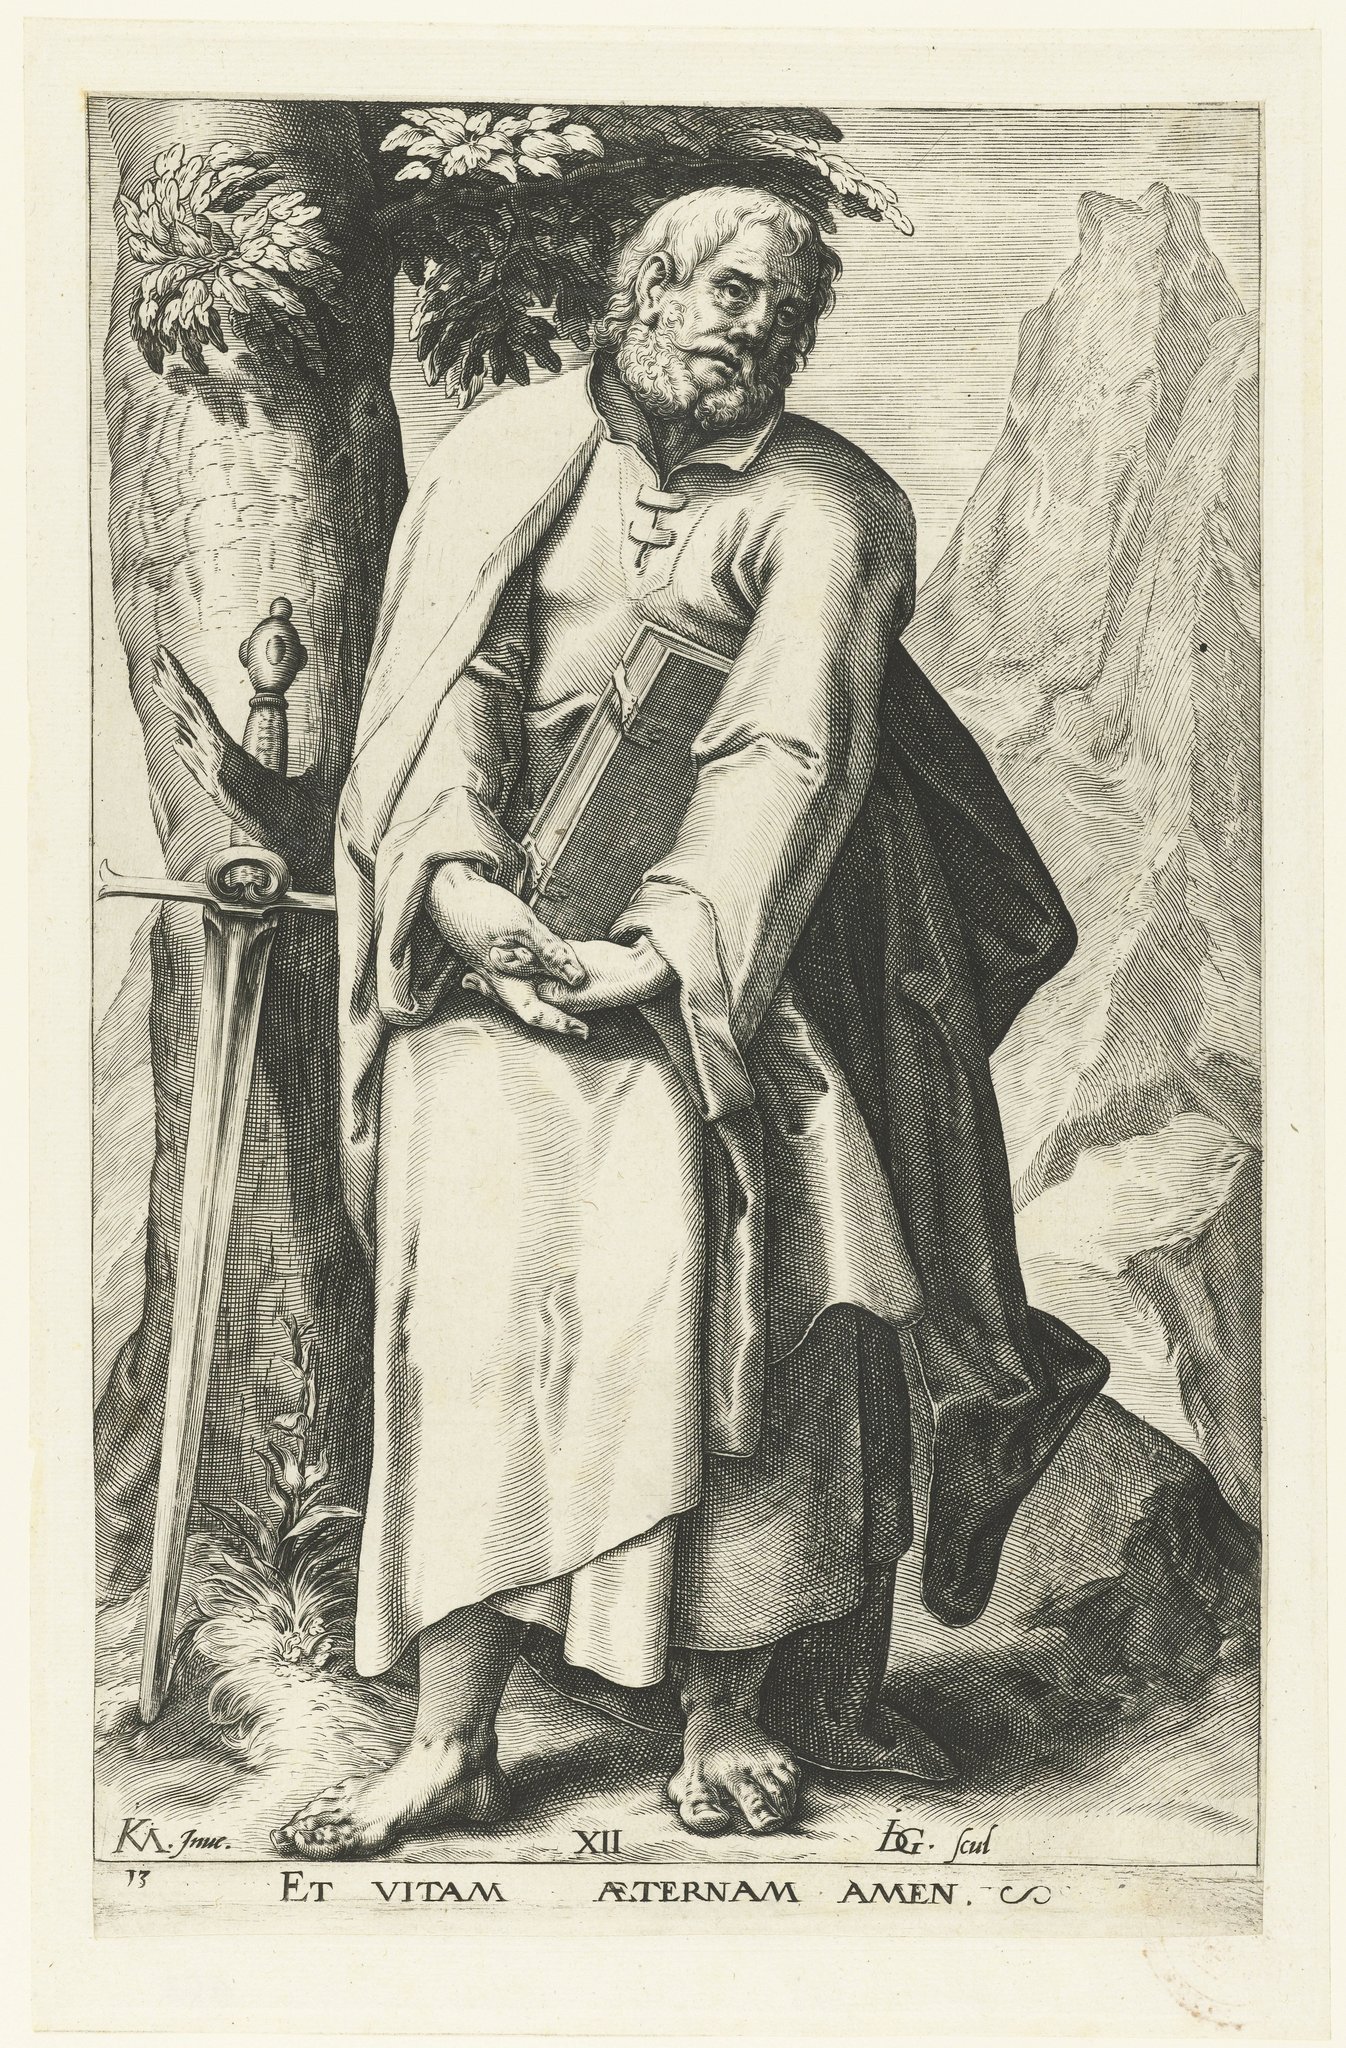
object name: print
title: Christus, de twaalf apostelen en de heilige Paulus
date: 1591-1592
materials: paper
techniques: engraving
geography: amsterdam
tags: the apostle and martyr matthias; possible attributes: axe, book, cross, halberd, scroll, sword, 'vitam aeternam' ~ articles of faith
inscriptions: collector's mark: Lugt 240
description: De apostel Matthias, staand bij een boom in een bergachtig landschap, in de gevouwen handen een boek, tegen de boom een zwaard. Onder de voorstelling een regel Latijnse tekst. Deze prent is onderdeel van een serie van 14 prenten, elk bestaand uit een beeltenis ten voeten uit van een apostel, Christus of Paulus met typerende attributen en een onderschrift in Latijn.